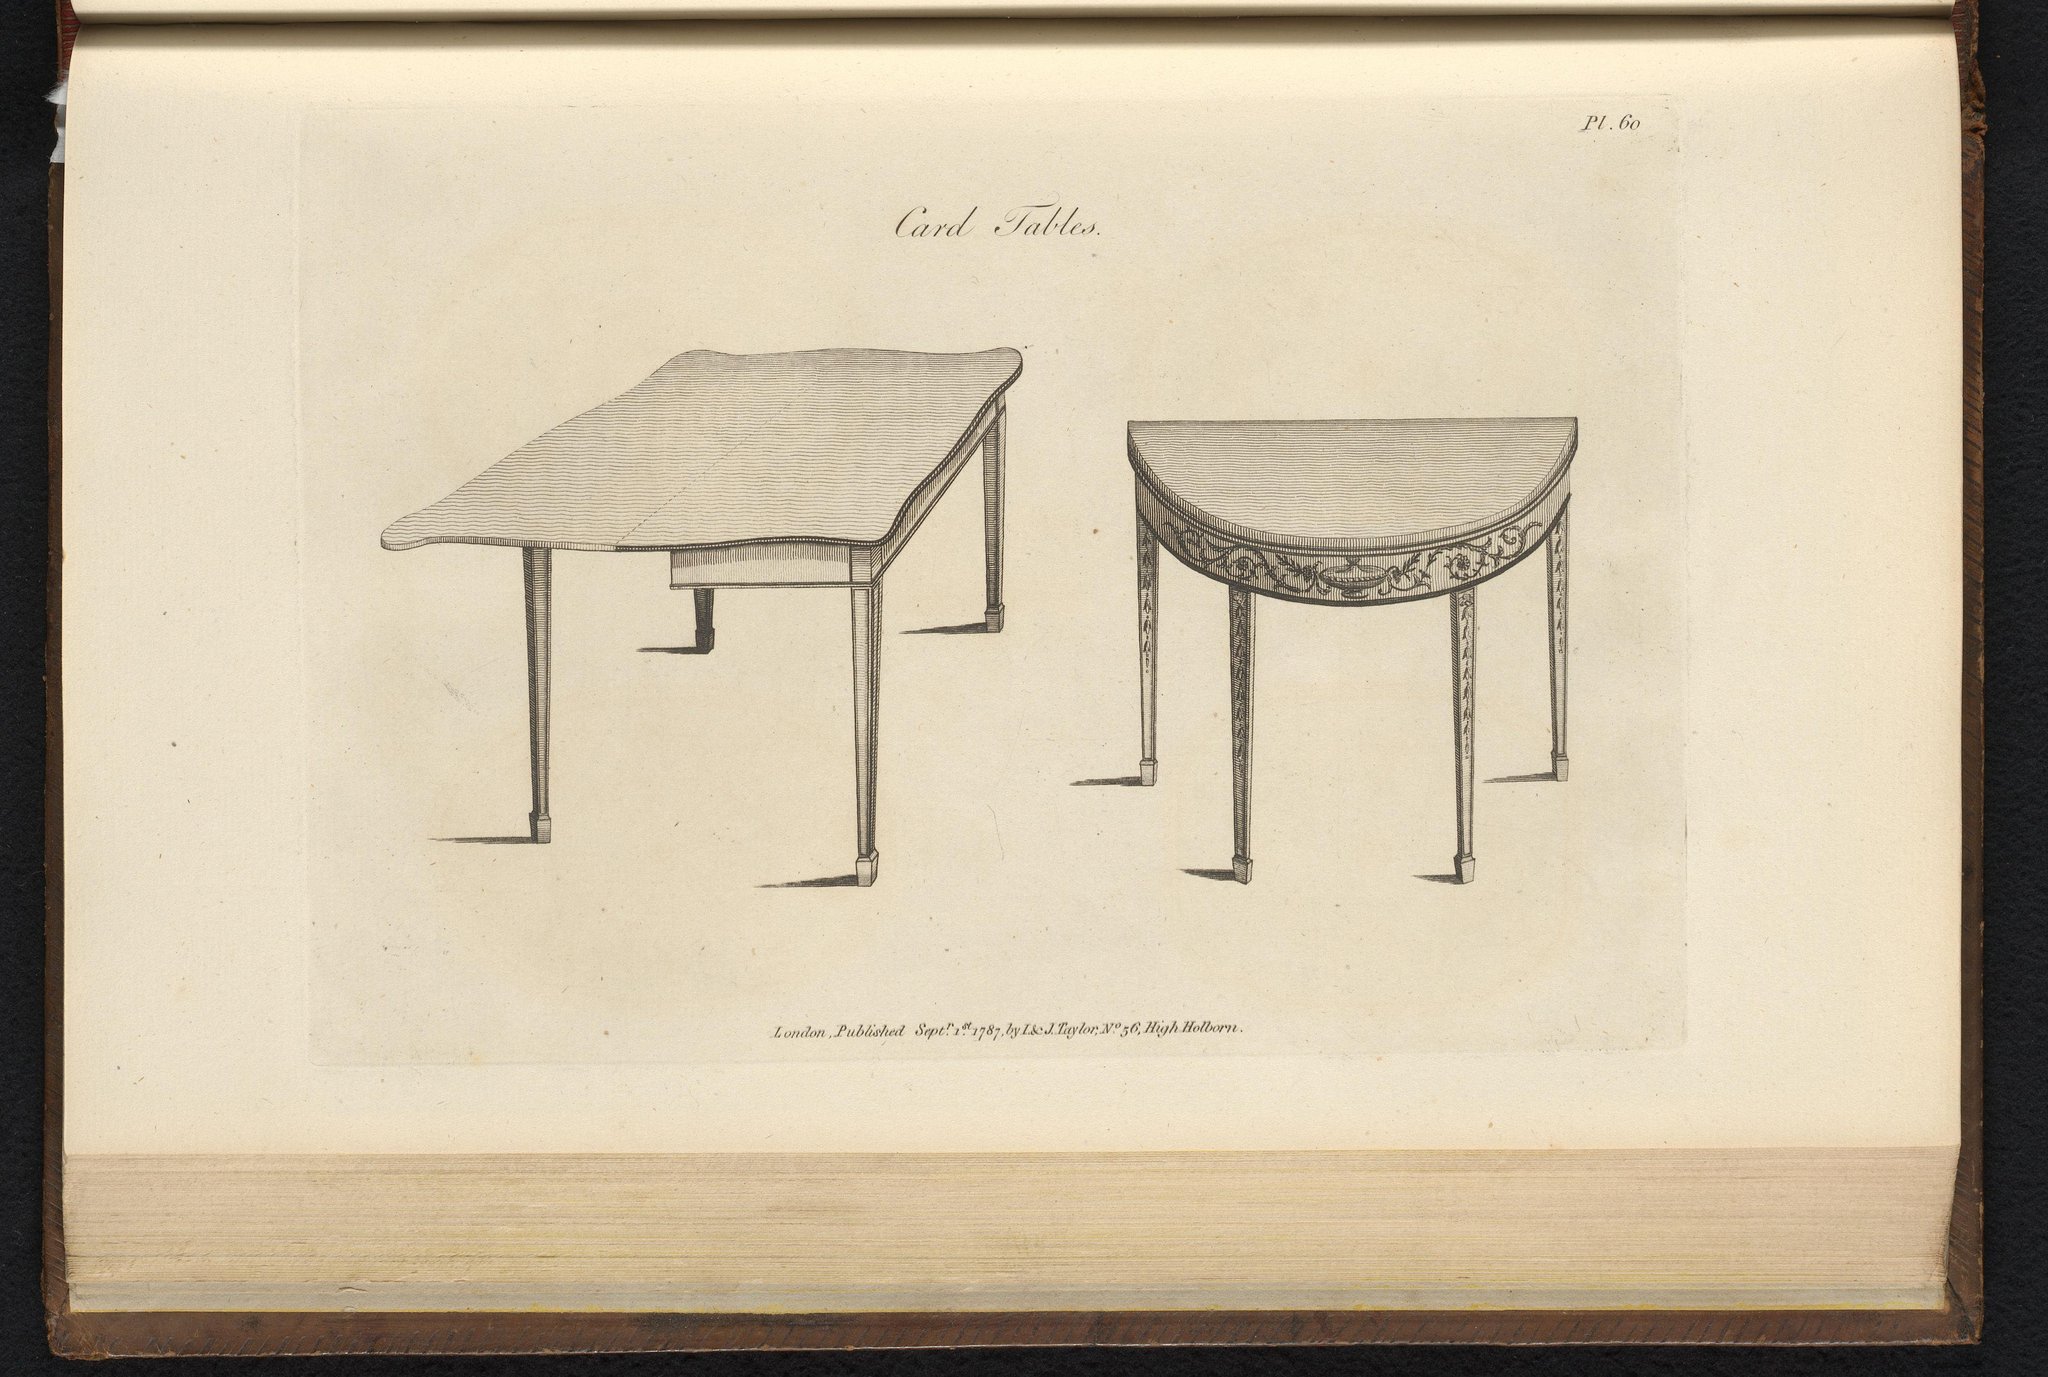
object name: page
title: Meubels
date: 1787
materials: paper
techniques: engraving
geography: holborn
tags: table, playing-cards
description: Genummerd: Pl. 60. Prent maakt deel uit van een boek.